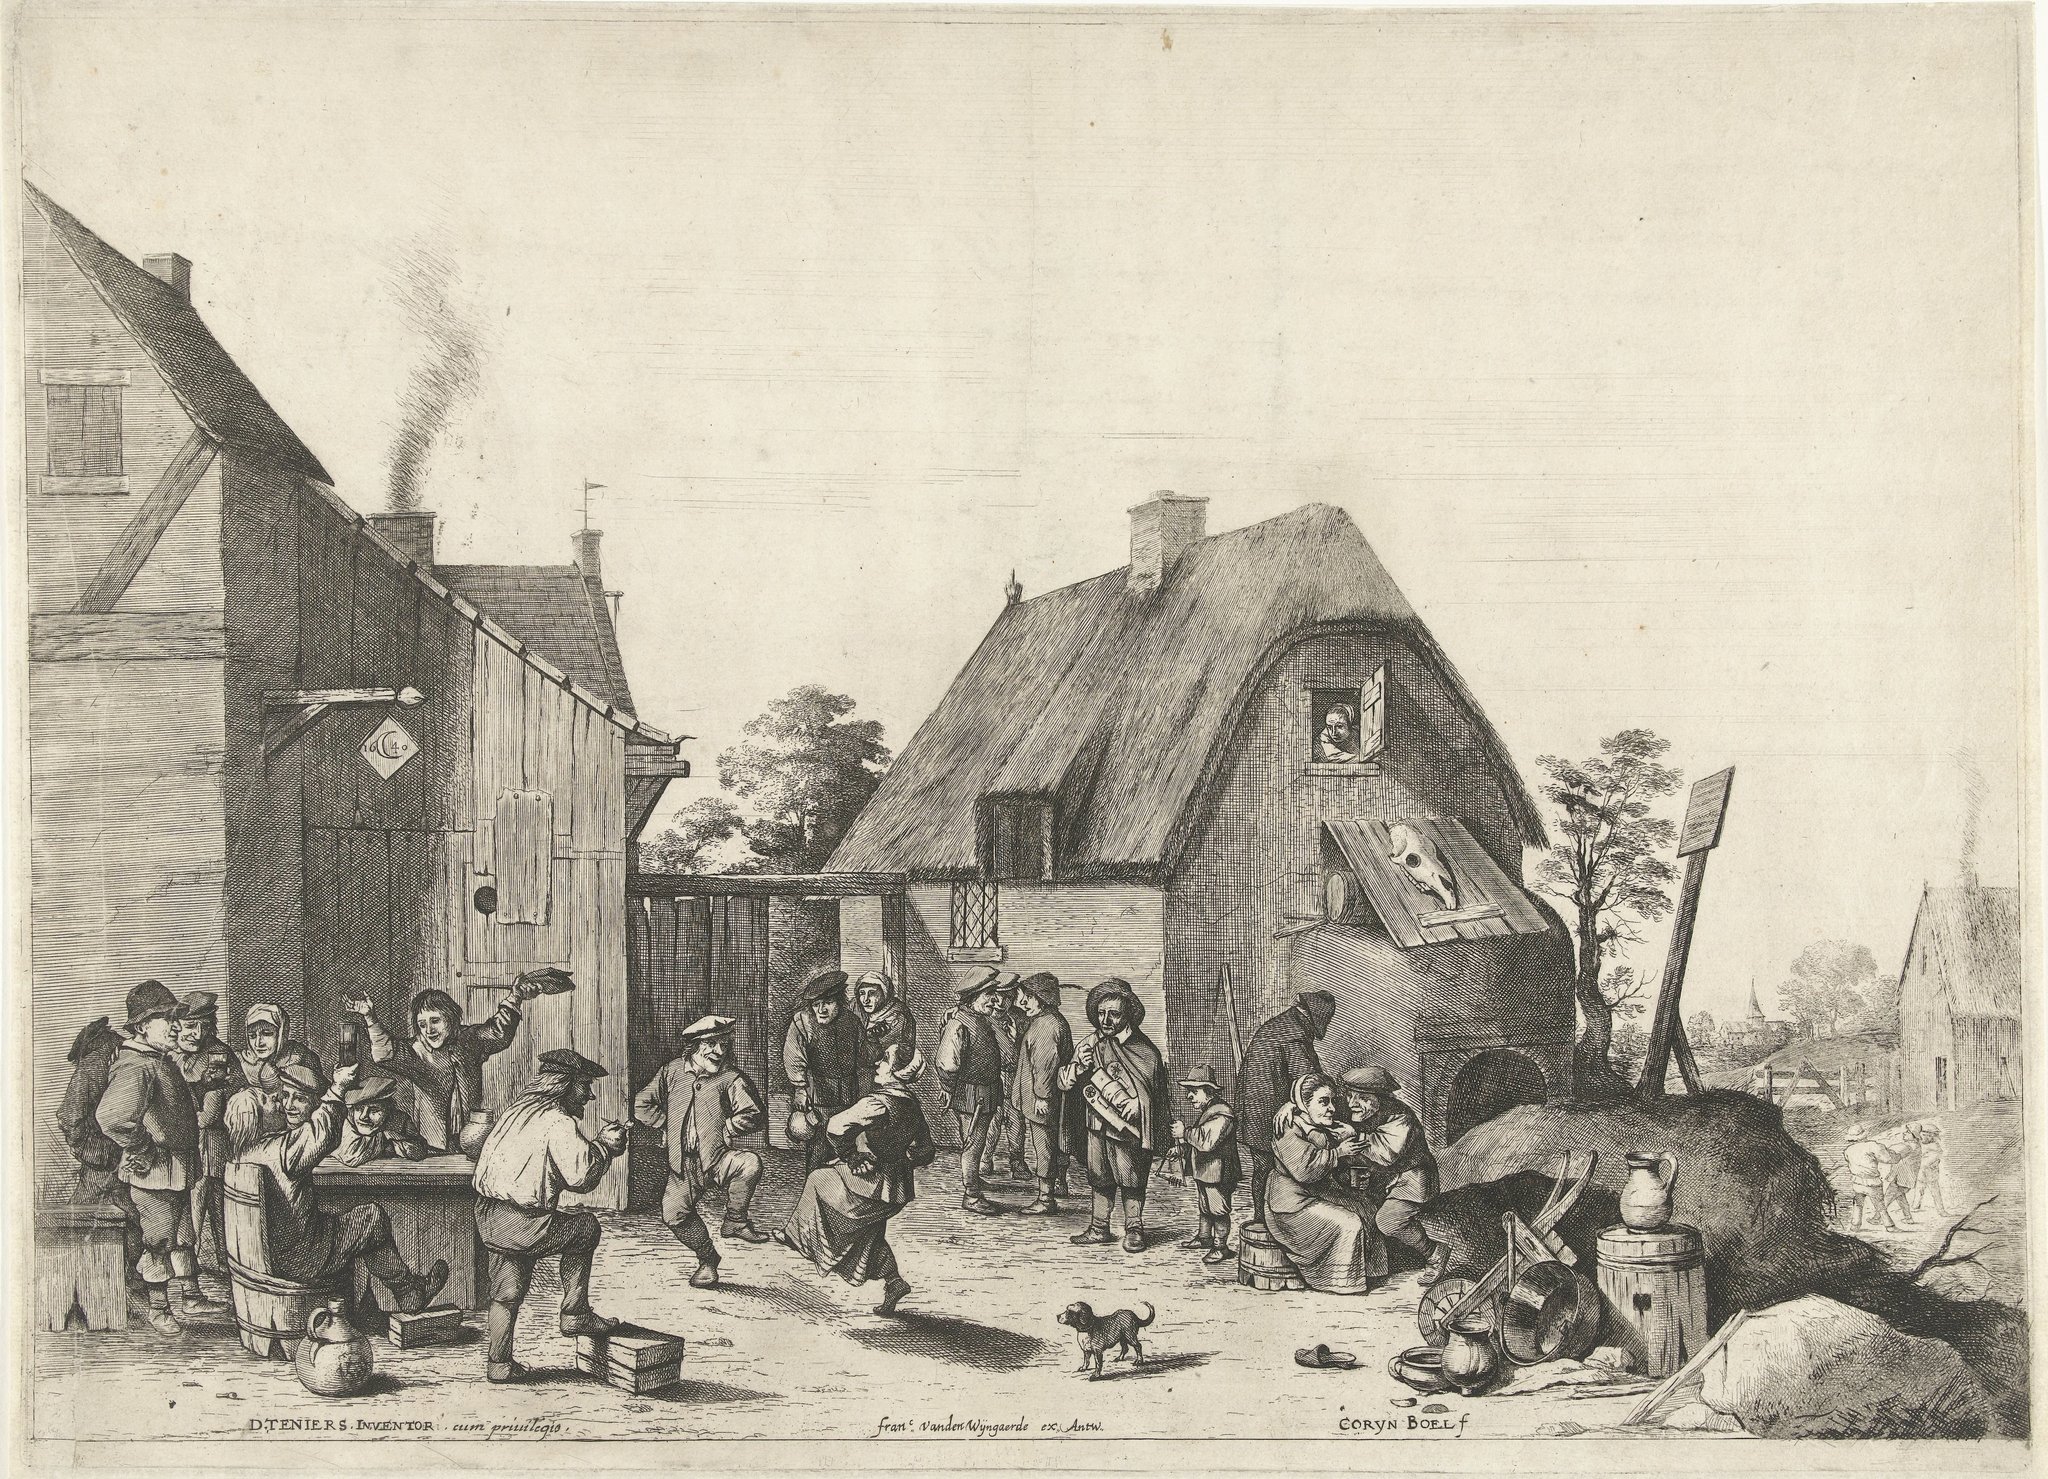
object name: print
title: Boerenerf met dansende en drinkende boeren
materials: paper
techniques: etching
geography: antwerp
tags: public festivities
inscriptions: name: ‘G. Storck a Milano 1798 In no. 7063’ Lugt 2319, collector's mark: Lugt 2228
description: Op een boerenerf vindt een feest plaats. Een man en een jongen maken muziek en een boerenstel danst erbij. De andere boeren zitten te drinken en te kletsen.